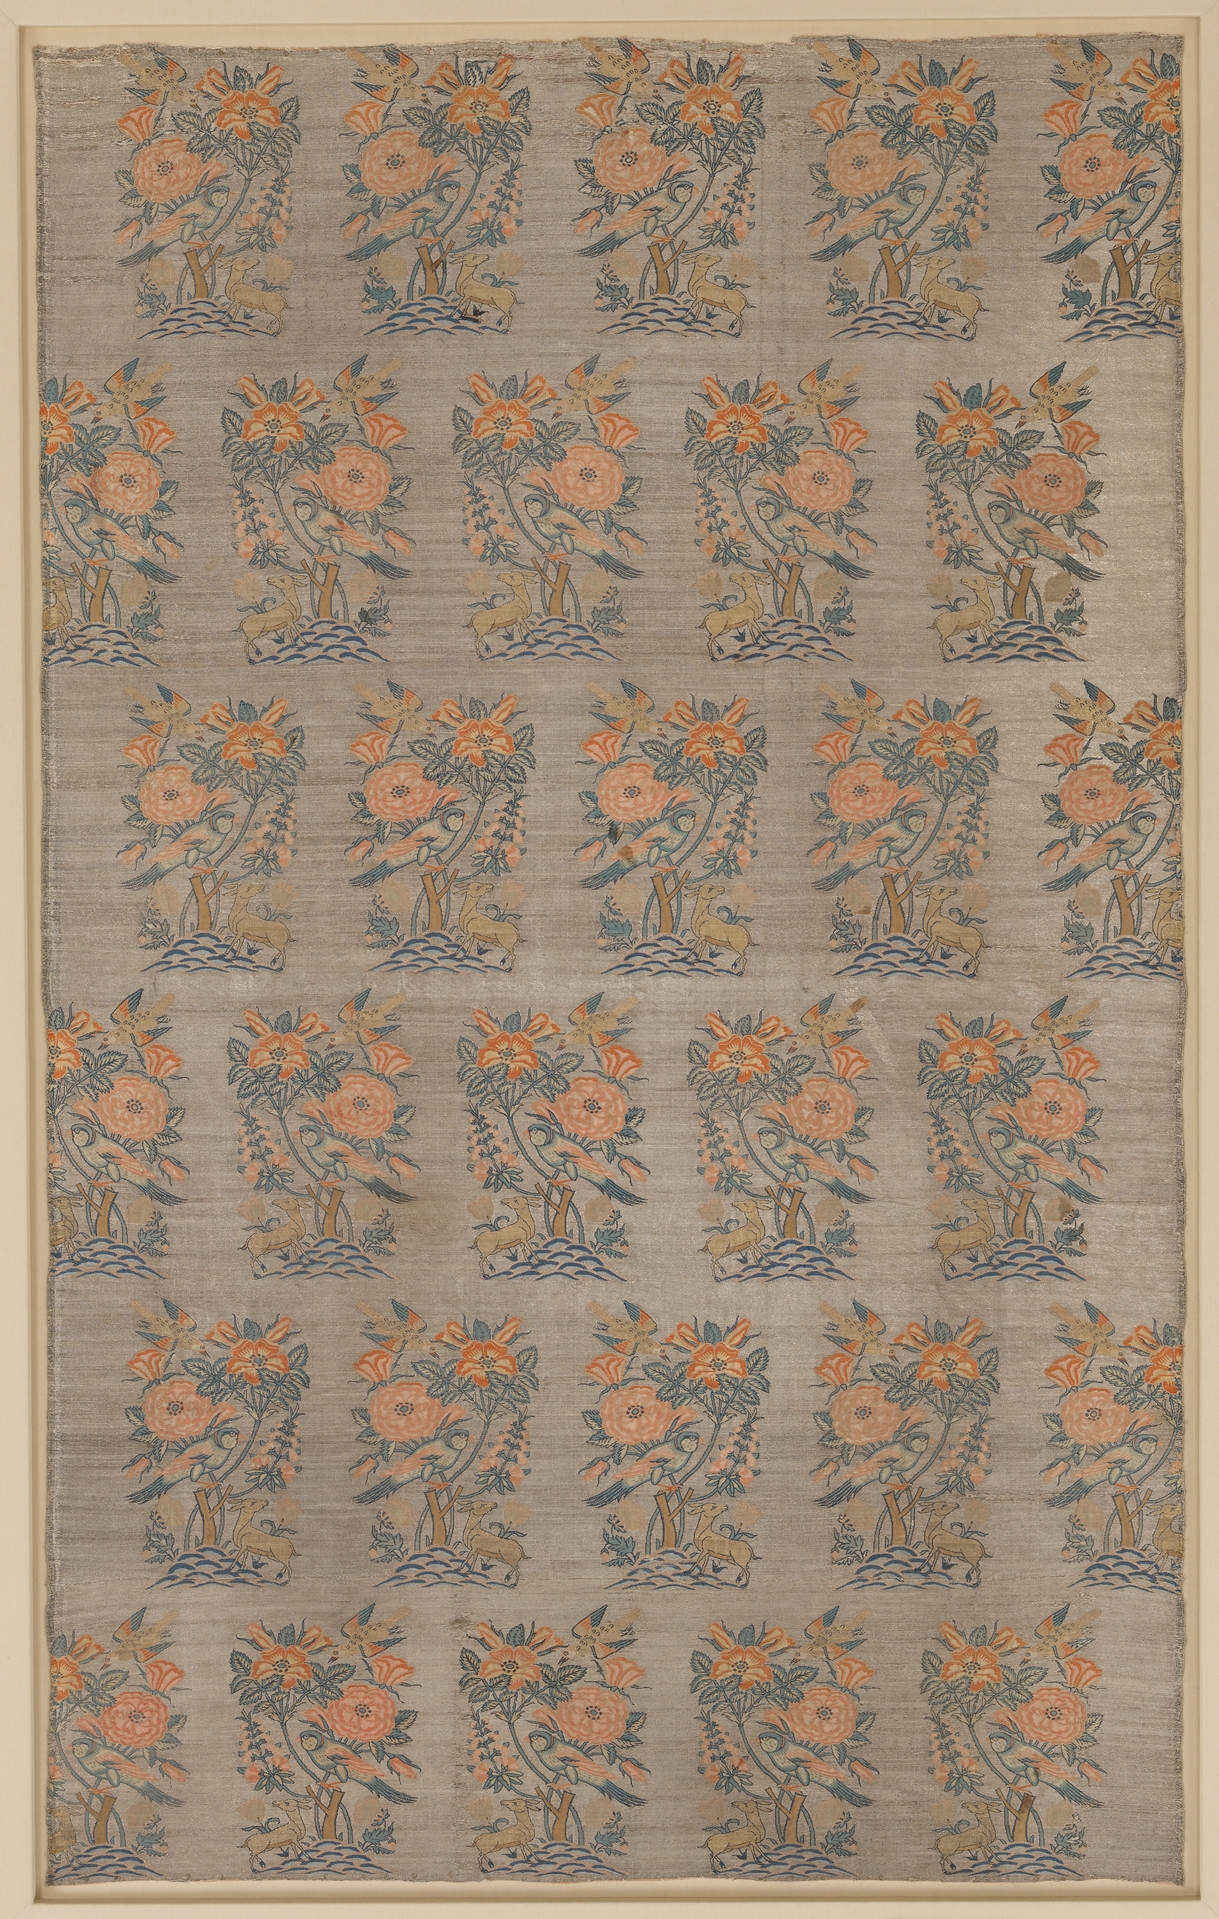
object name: textile fragment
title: Panel with Rosebush, Birds, and Deer Pattern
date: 1667-1733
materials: metal thread, silk, silver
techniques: brocade, gilding, weave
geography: iran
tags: birds,deer,roses